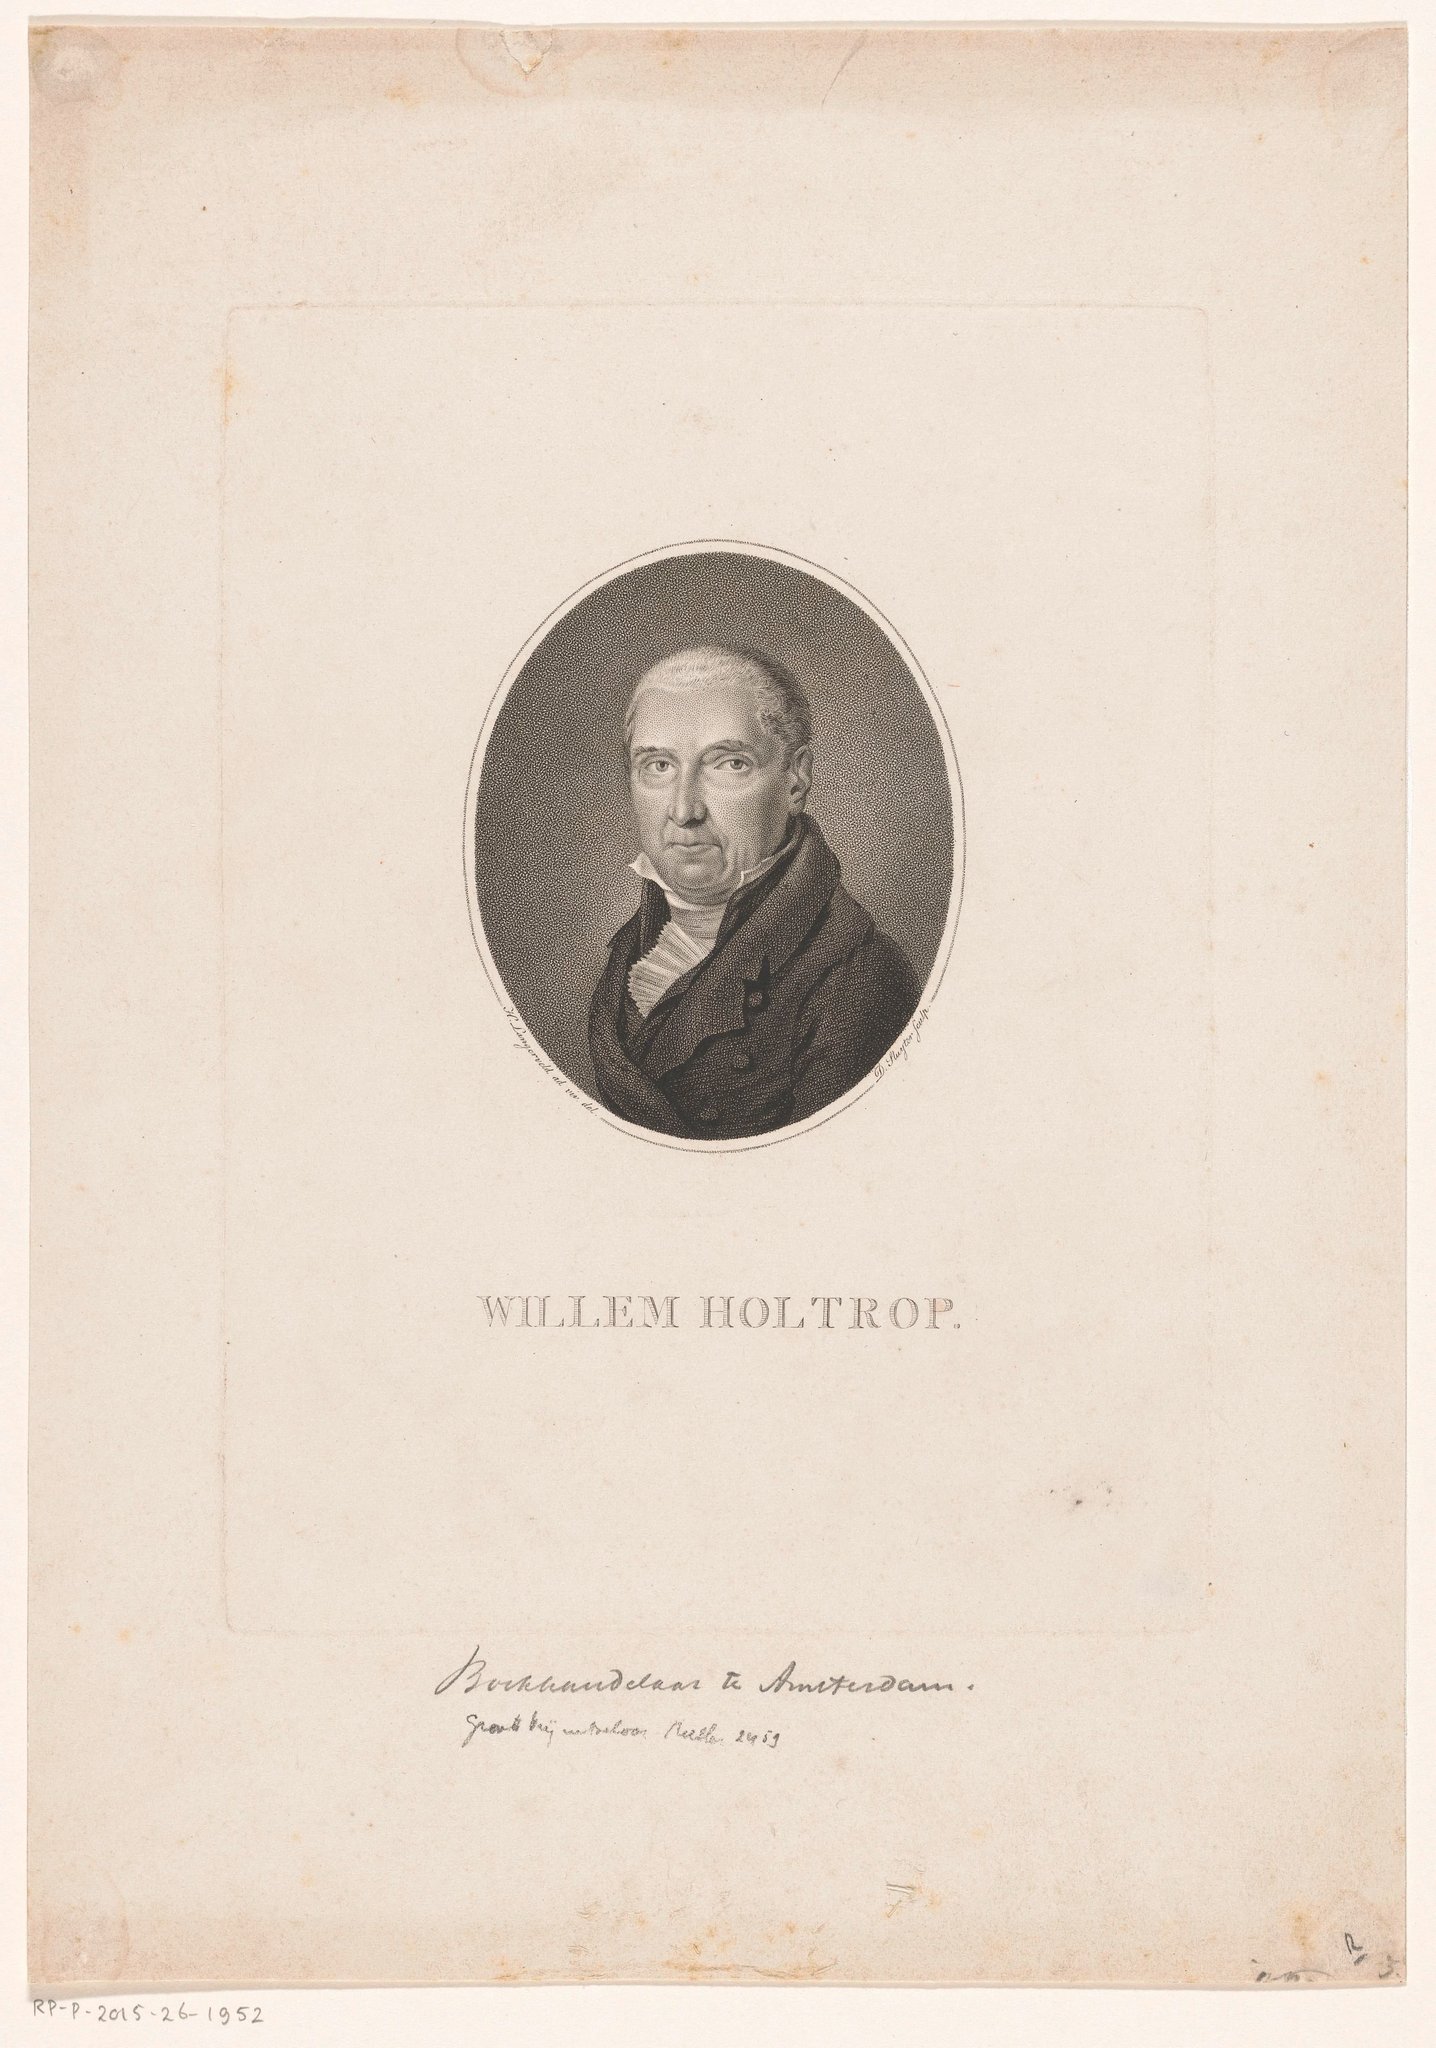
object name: print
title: Portret van Willem Holtrop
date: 1805-1852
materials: paper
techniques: engraving, etching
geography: amsterdam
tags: willem holtrop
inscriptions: collector's mark: Lugt 4780, collector's mark: Lugt 2228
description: Portret van Willem Holtrop, boekhandelaar, uitgever en lid van de vrijmetselaars.